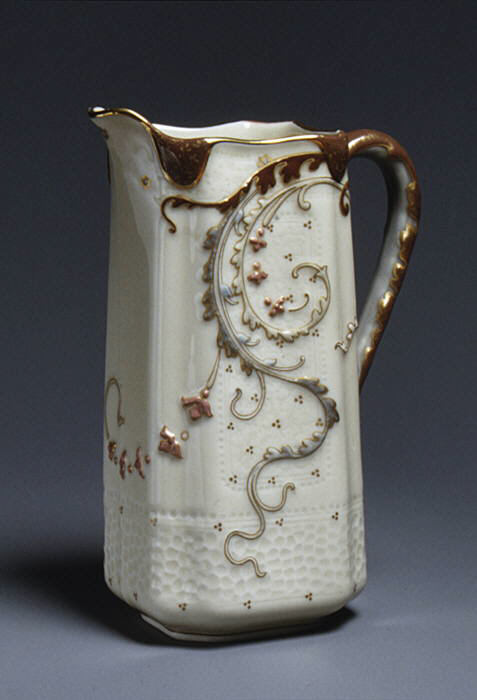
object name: pitcher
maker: albert-louis dammouse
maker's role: designer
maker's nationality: french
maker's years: 1848-1926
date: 1879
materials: hard paste porcelain